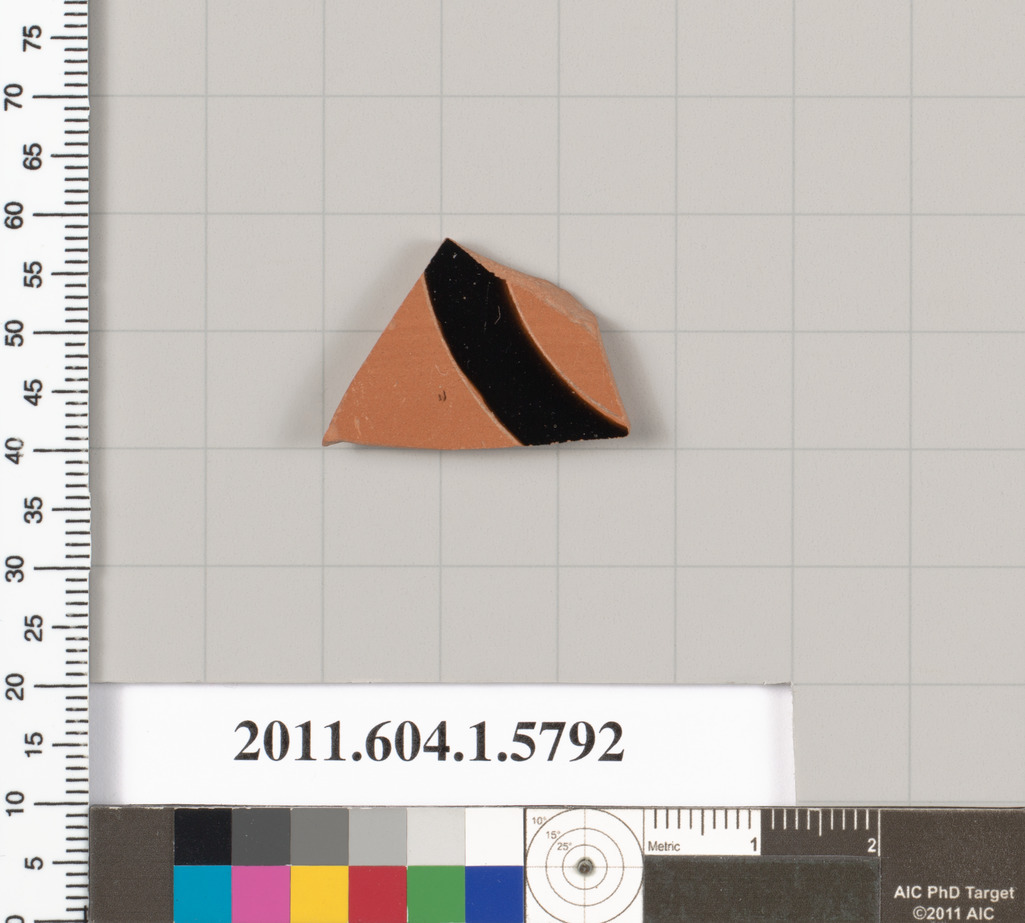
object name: kylix fragment, eye cup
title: Terracotta fragment of a kylix: eye-cup (drinking cup)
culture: greek, attic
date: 520-510 BCE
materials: terracotta